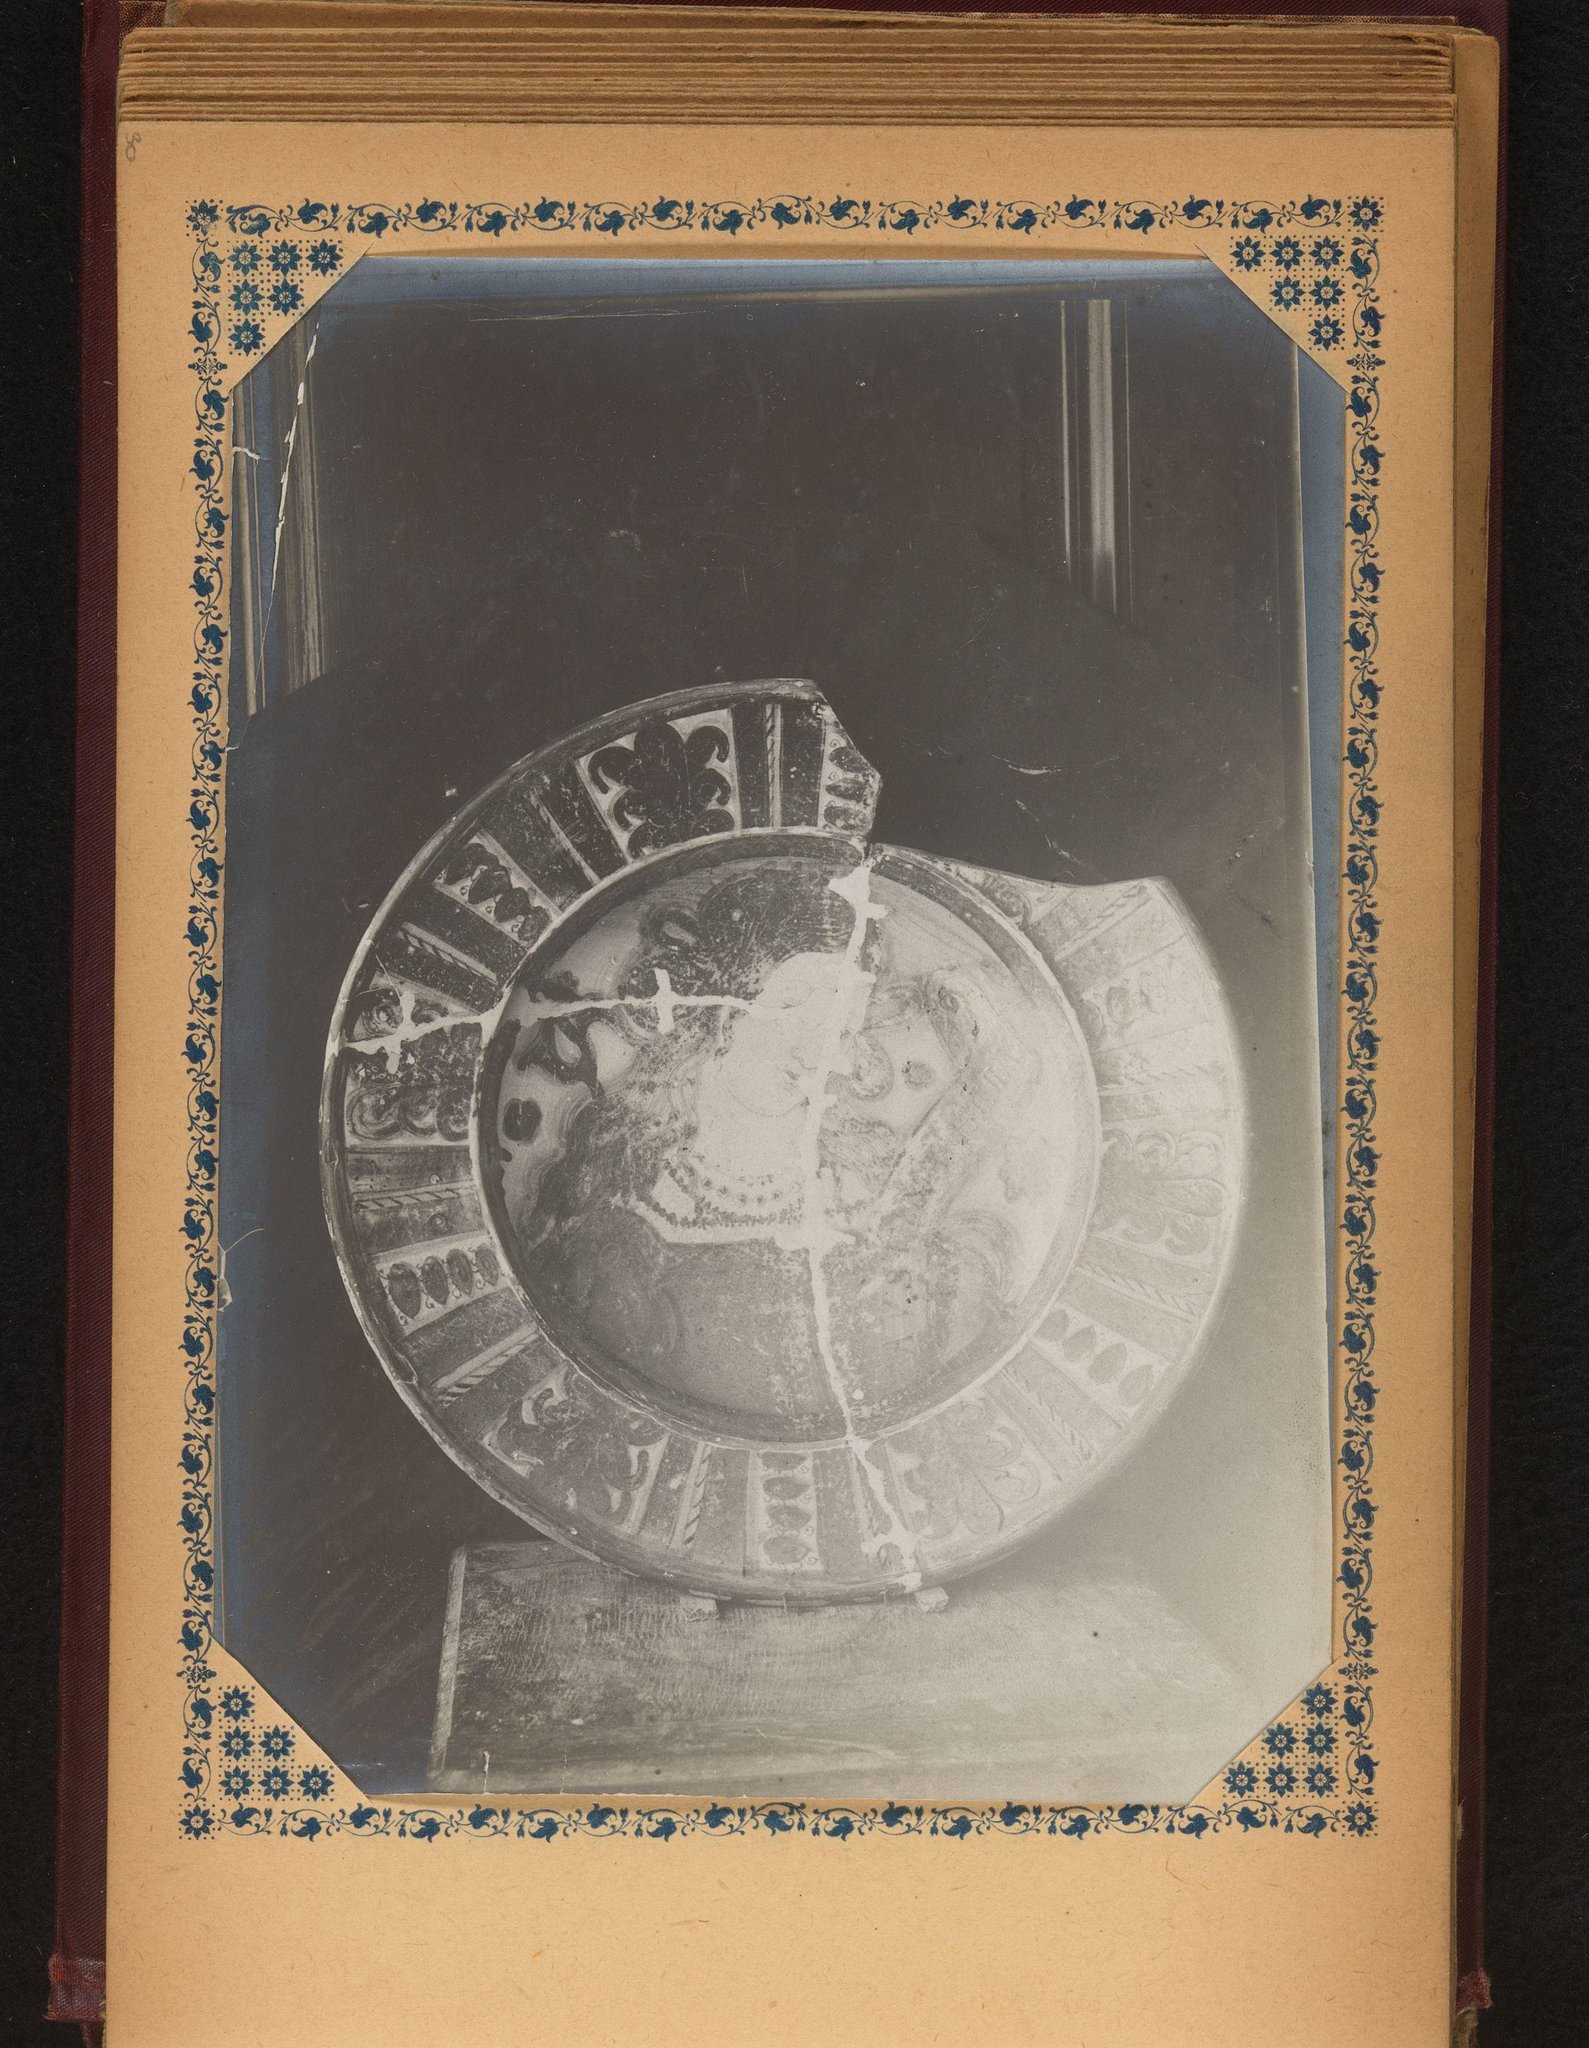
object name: album leaf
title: Bord beschilderd met een borstbeeld van een vrouw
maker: Anonymous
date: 1880-1940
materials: cardboard, photographic support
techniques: gelatin silver print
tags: adult woman (+ right side visible; right - (r. hand, r. foot, etc.)), dish, plate, saucer